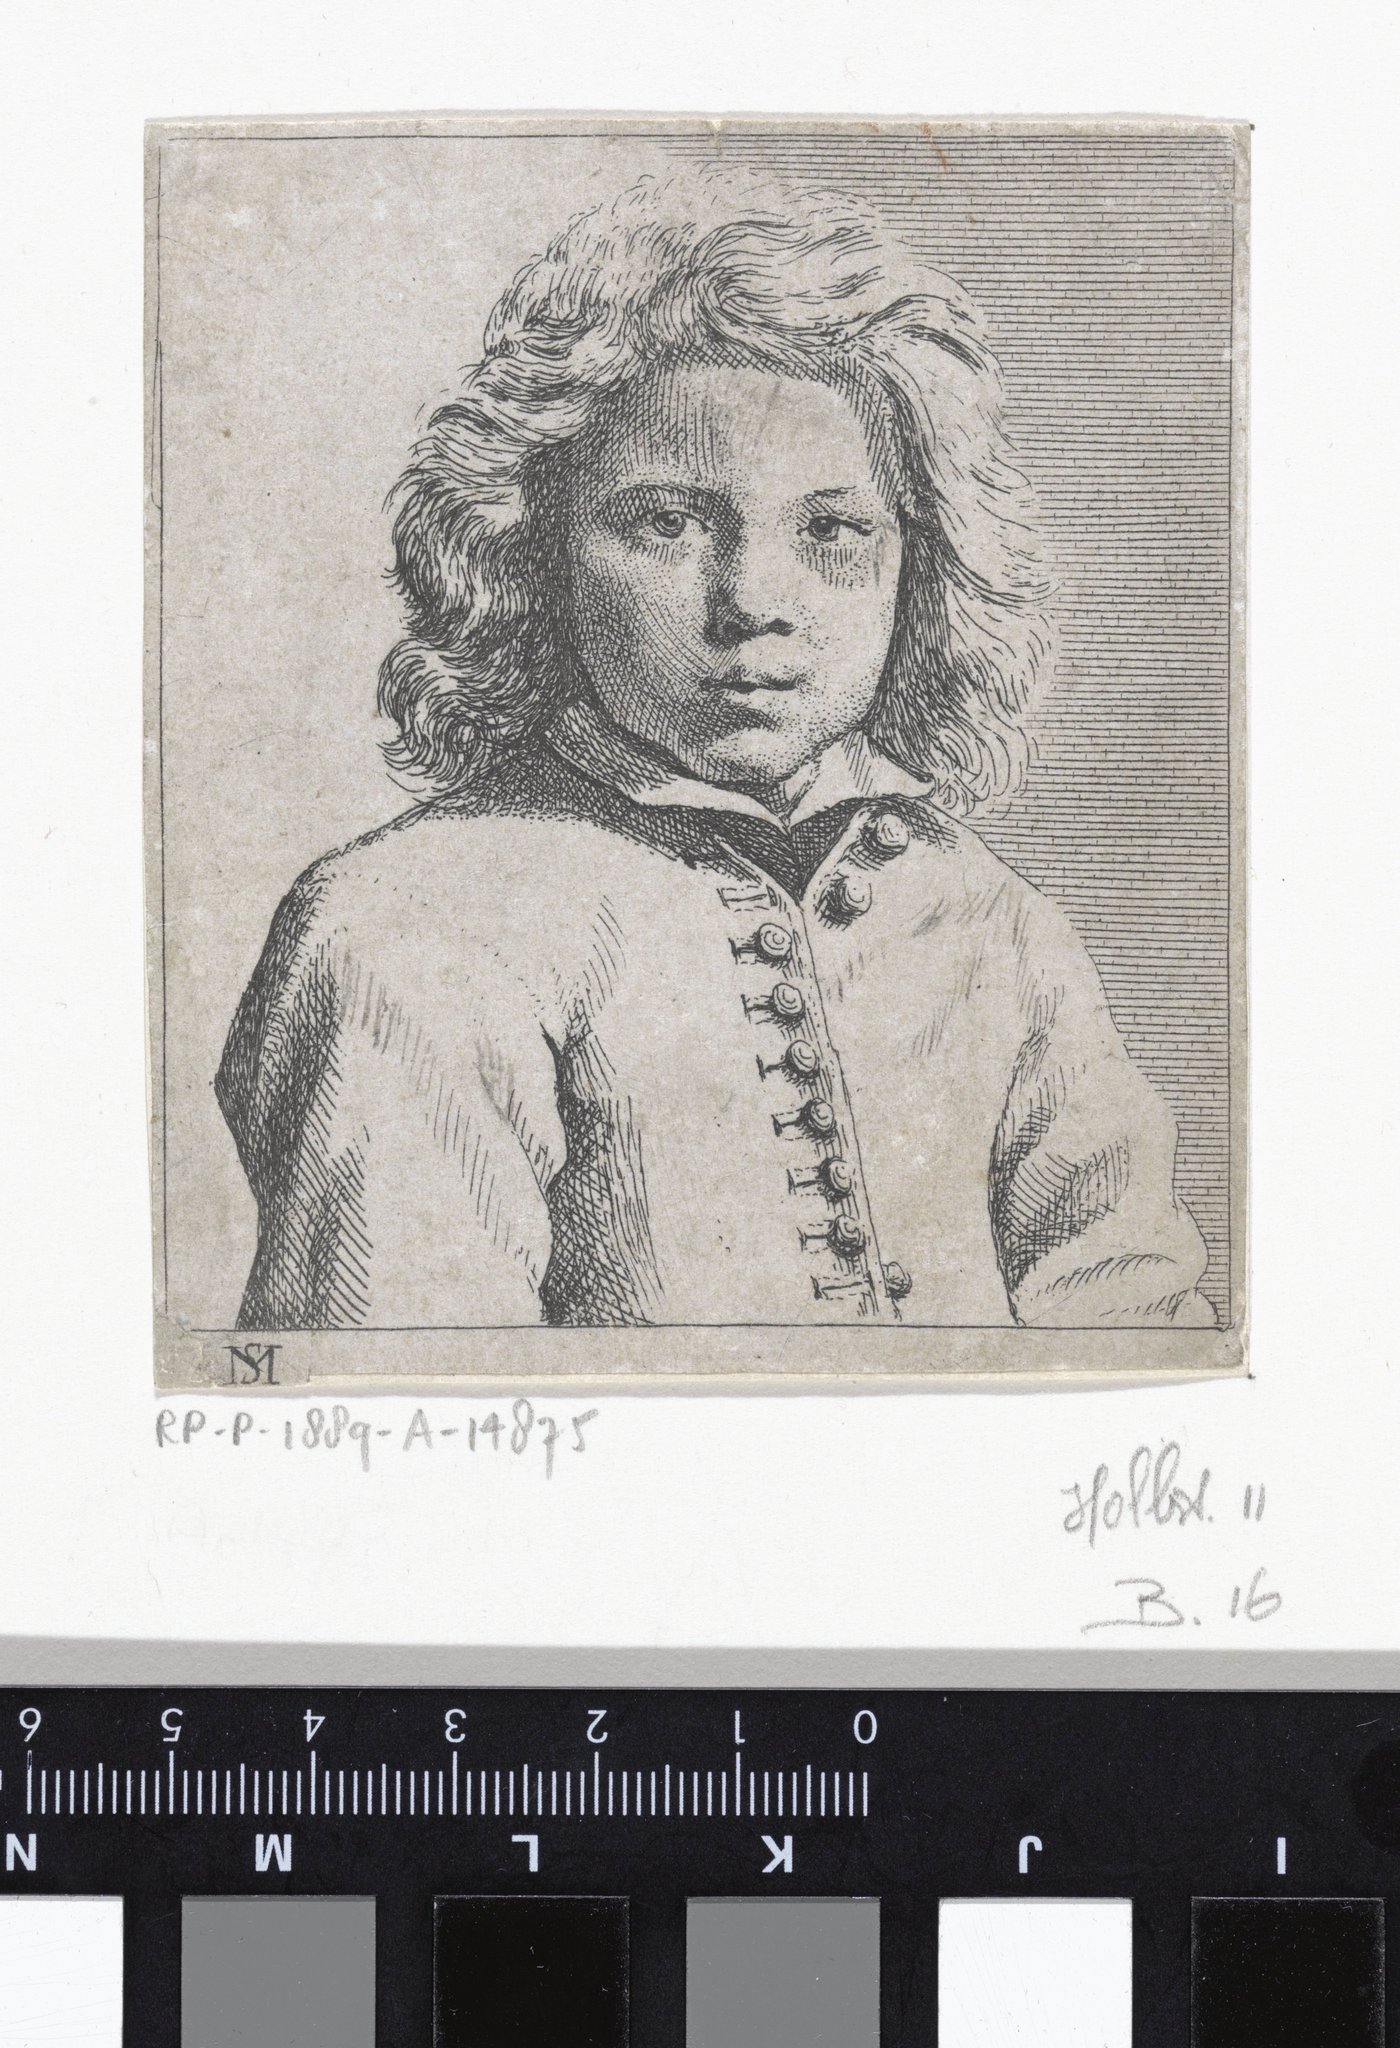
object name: print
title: Michael Sweerts (1618-1664), etchings, 1656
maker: michael sweerts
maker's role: painter, print maker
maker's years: 1618-1664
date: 1656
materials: paper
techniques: engraving, etching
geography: brussels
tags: boy (child between toddler and youth)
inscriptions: collector's mark: Lugt 2228, inscription: ‘M. Sweerts fec.’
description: Thirteen lifelike faces from 1656 look back, or away from us. The figures differ in gender, age, clothing style, and facial expression. In Brussels, Michael Sweerts gave drawing lessons to artists in training. This series may have been part of his teaching material; students would use them to draw from models. While not portraits, the types were certainly meant to be recognizable, for instance as random passers-by in a typical 1656 street scene.